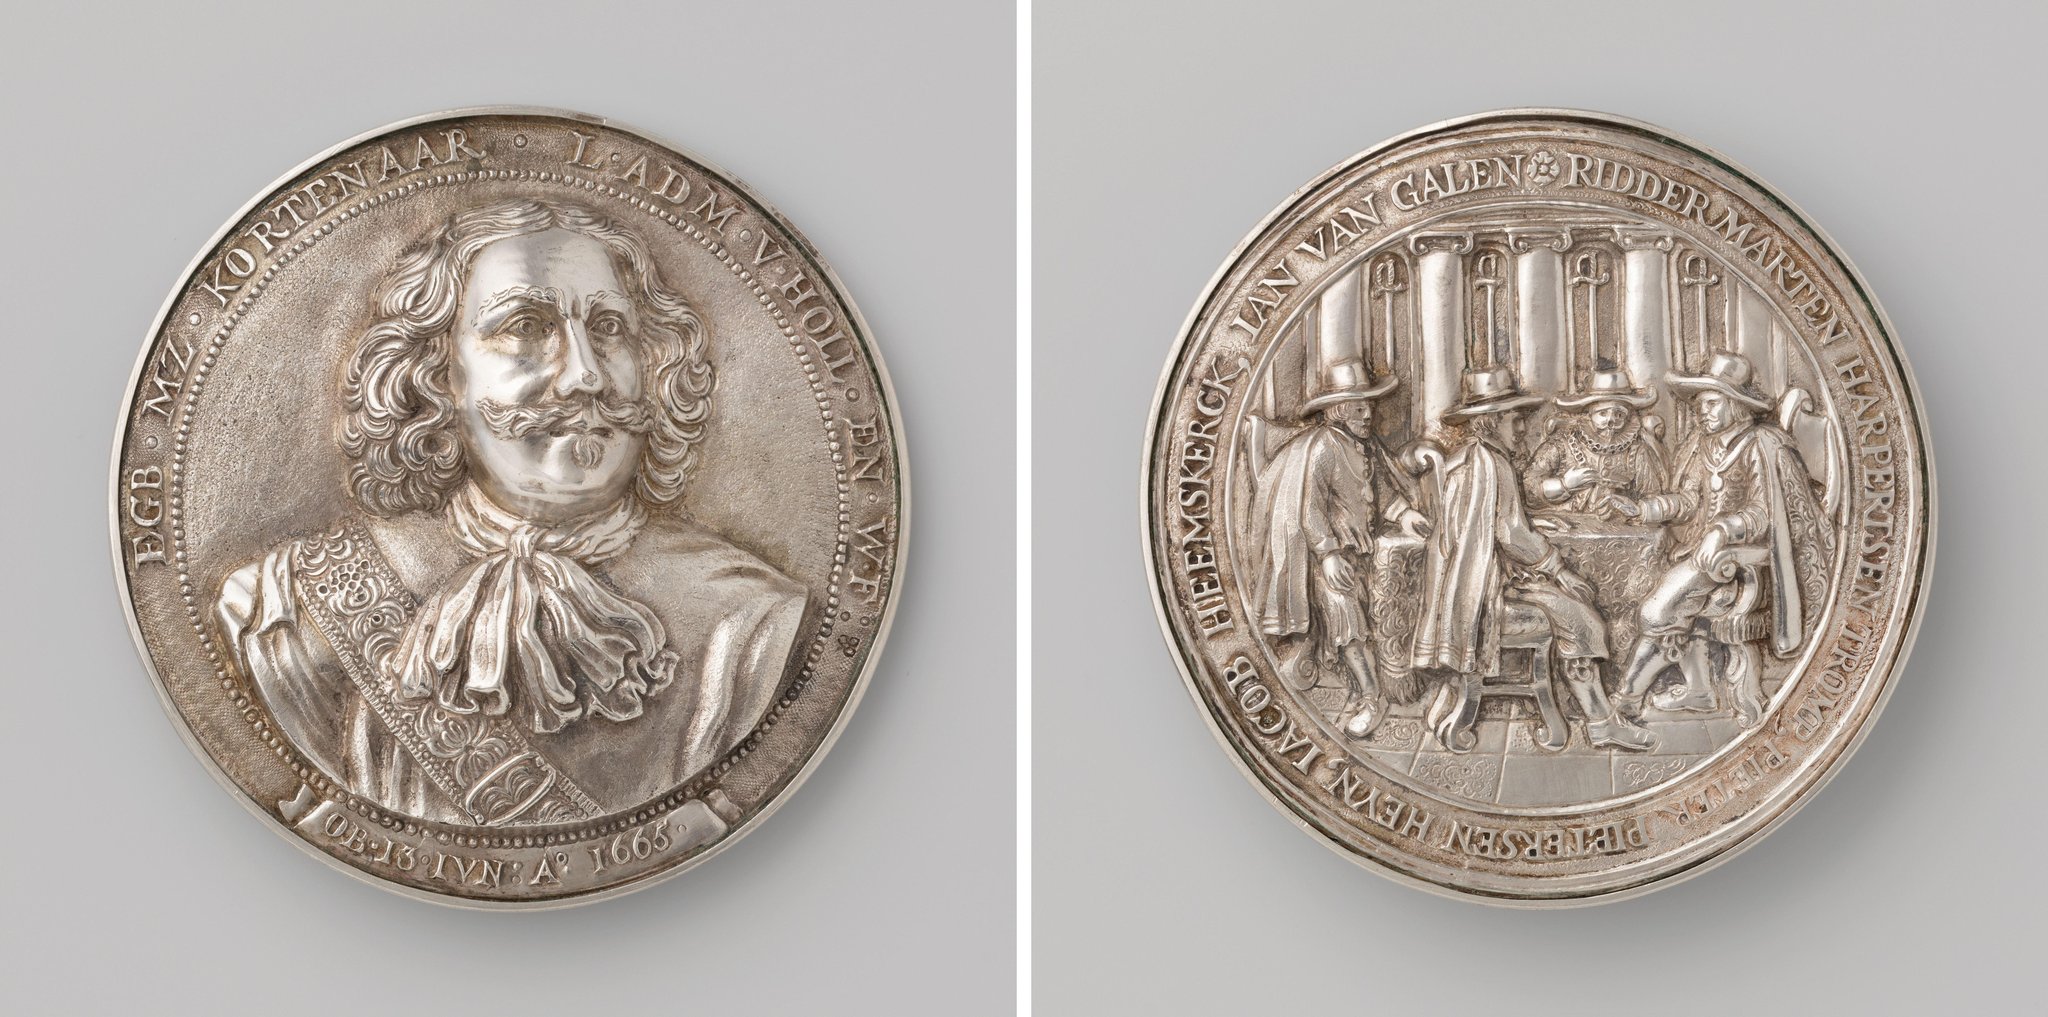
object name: honorary medal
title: Egbert Kortenaer, luitenant-admiraal van Holland en West-Friesland, gevallen in de slag bij Lowestoft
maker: wouter muller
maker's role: publisher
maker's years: 1604-1673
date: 1665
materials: silver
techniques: casting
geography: amsterdam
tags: delfshaven, jacob van heemskerck, brielle, maarten harpertszoon tromp, essen, commander-in-chief, admiral (+ naval force), battle of lowestoft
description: Zilveren penning. Voorzijde: borststuk man binnen omschrift. Keerzijde: vier gezagvoerders ter zee (Tromp, Hein, Heemskerck en Van Galen) gezeten aan tafel binnen omschrift.